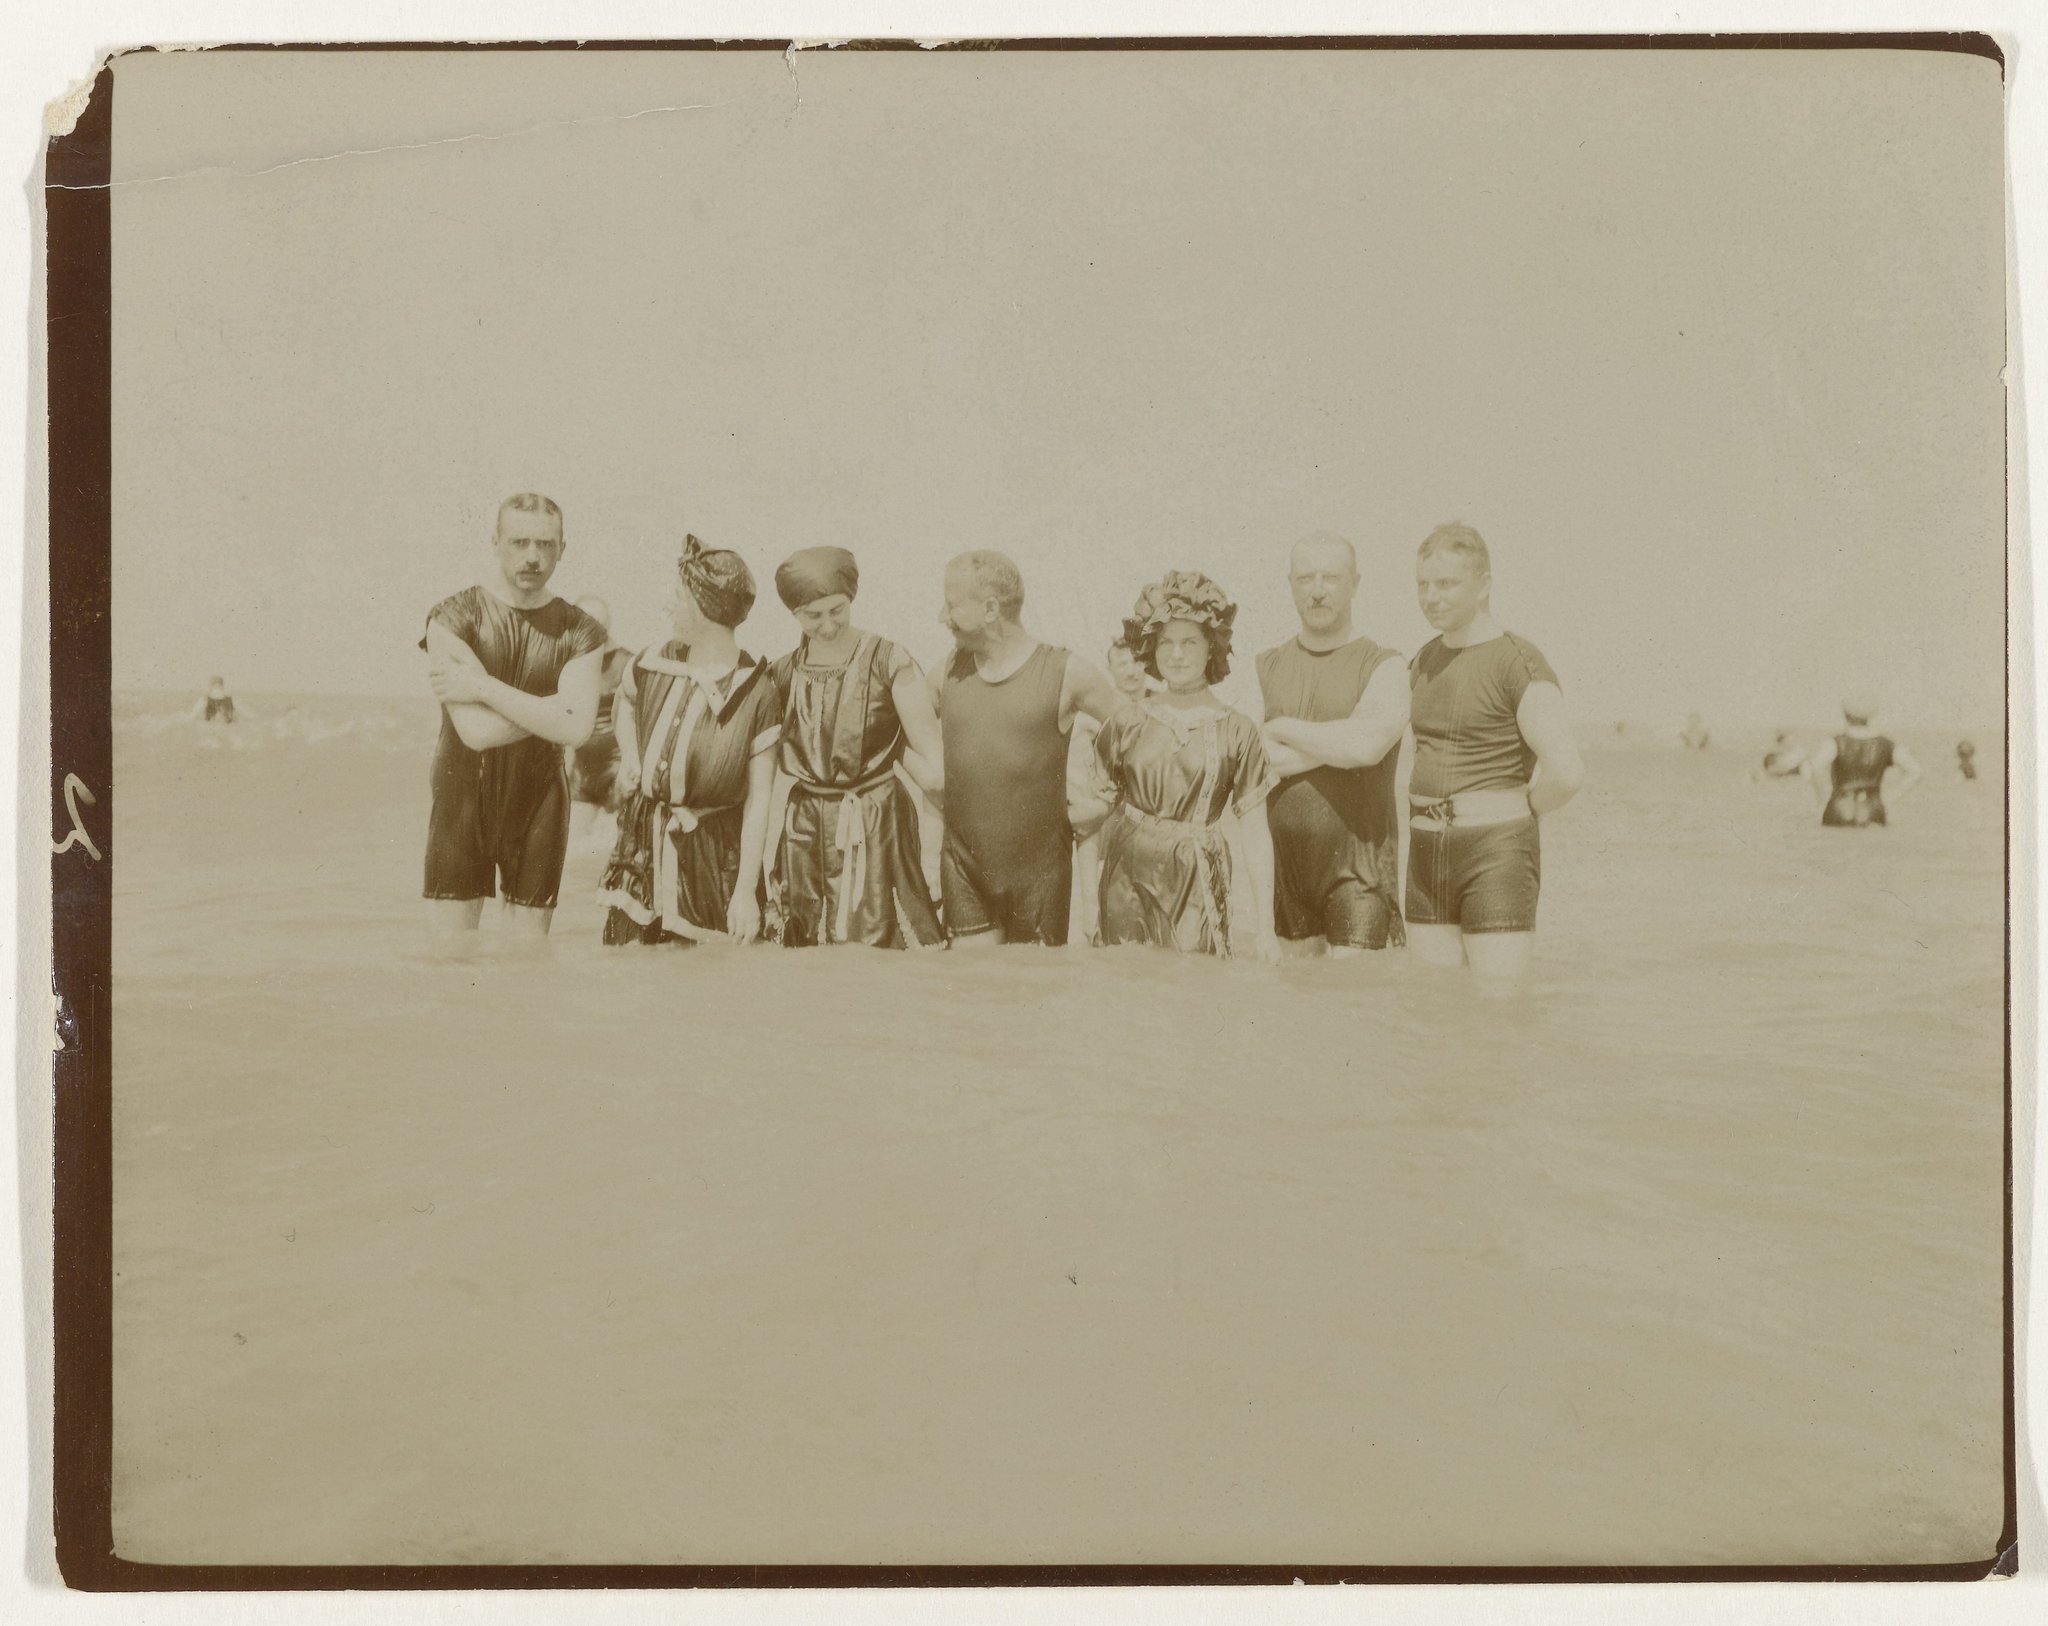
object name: photograph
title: Groepsportret van mensen in zee (Noordzeekust), Nederland of Duitsland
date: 1900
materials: paper, photographic support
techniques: gelatin silver print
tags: beach (as place of recreation), netherlands, germany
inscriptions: number: ‘109’